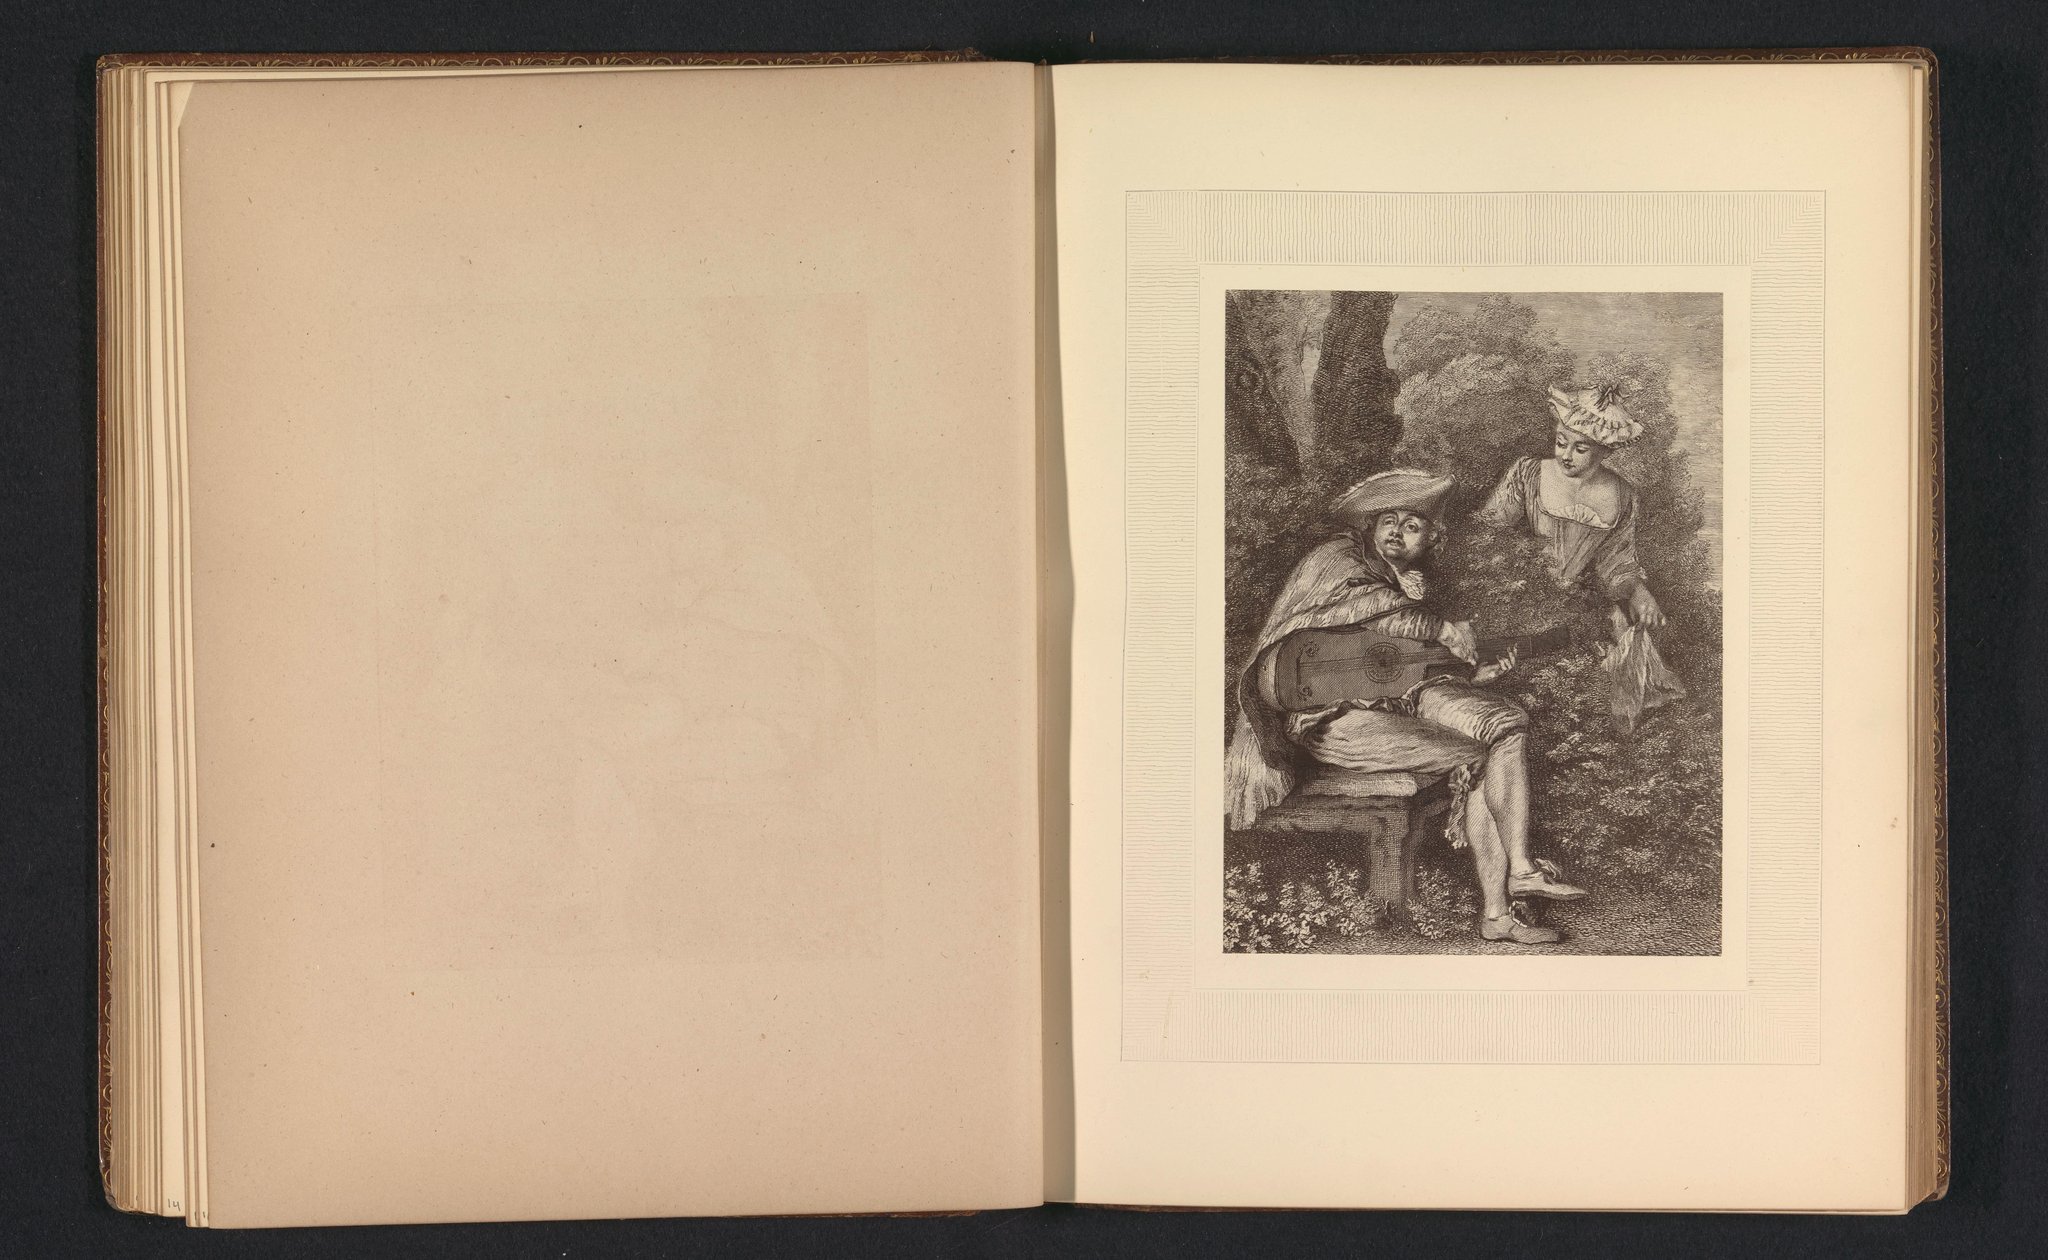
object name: page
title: Fotoreproductie van een prent naar een schilderij met een man die een vrouw een serenade brengt door Jean Antoine Watteau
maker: Anonymous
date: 1864-1874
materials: paper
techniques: woodburytype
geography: london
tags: picture, painting, serenade to the beloved